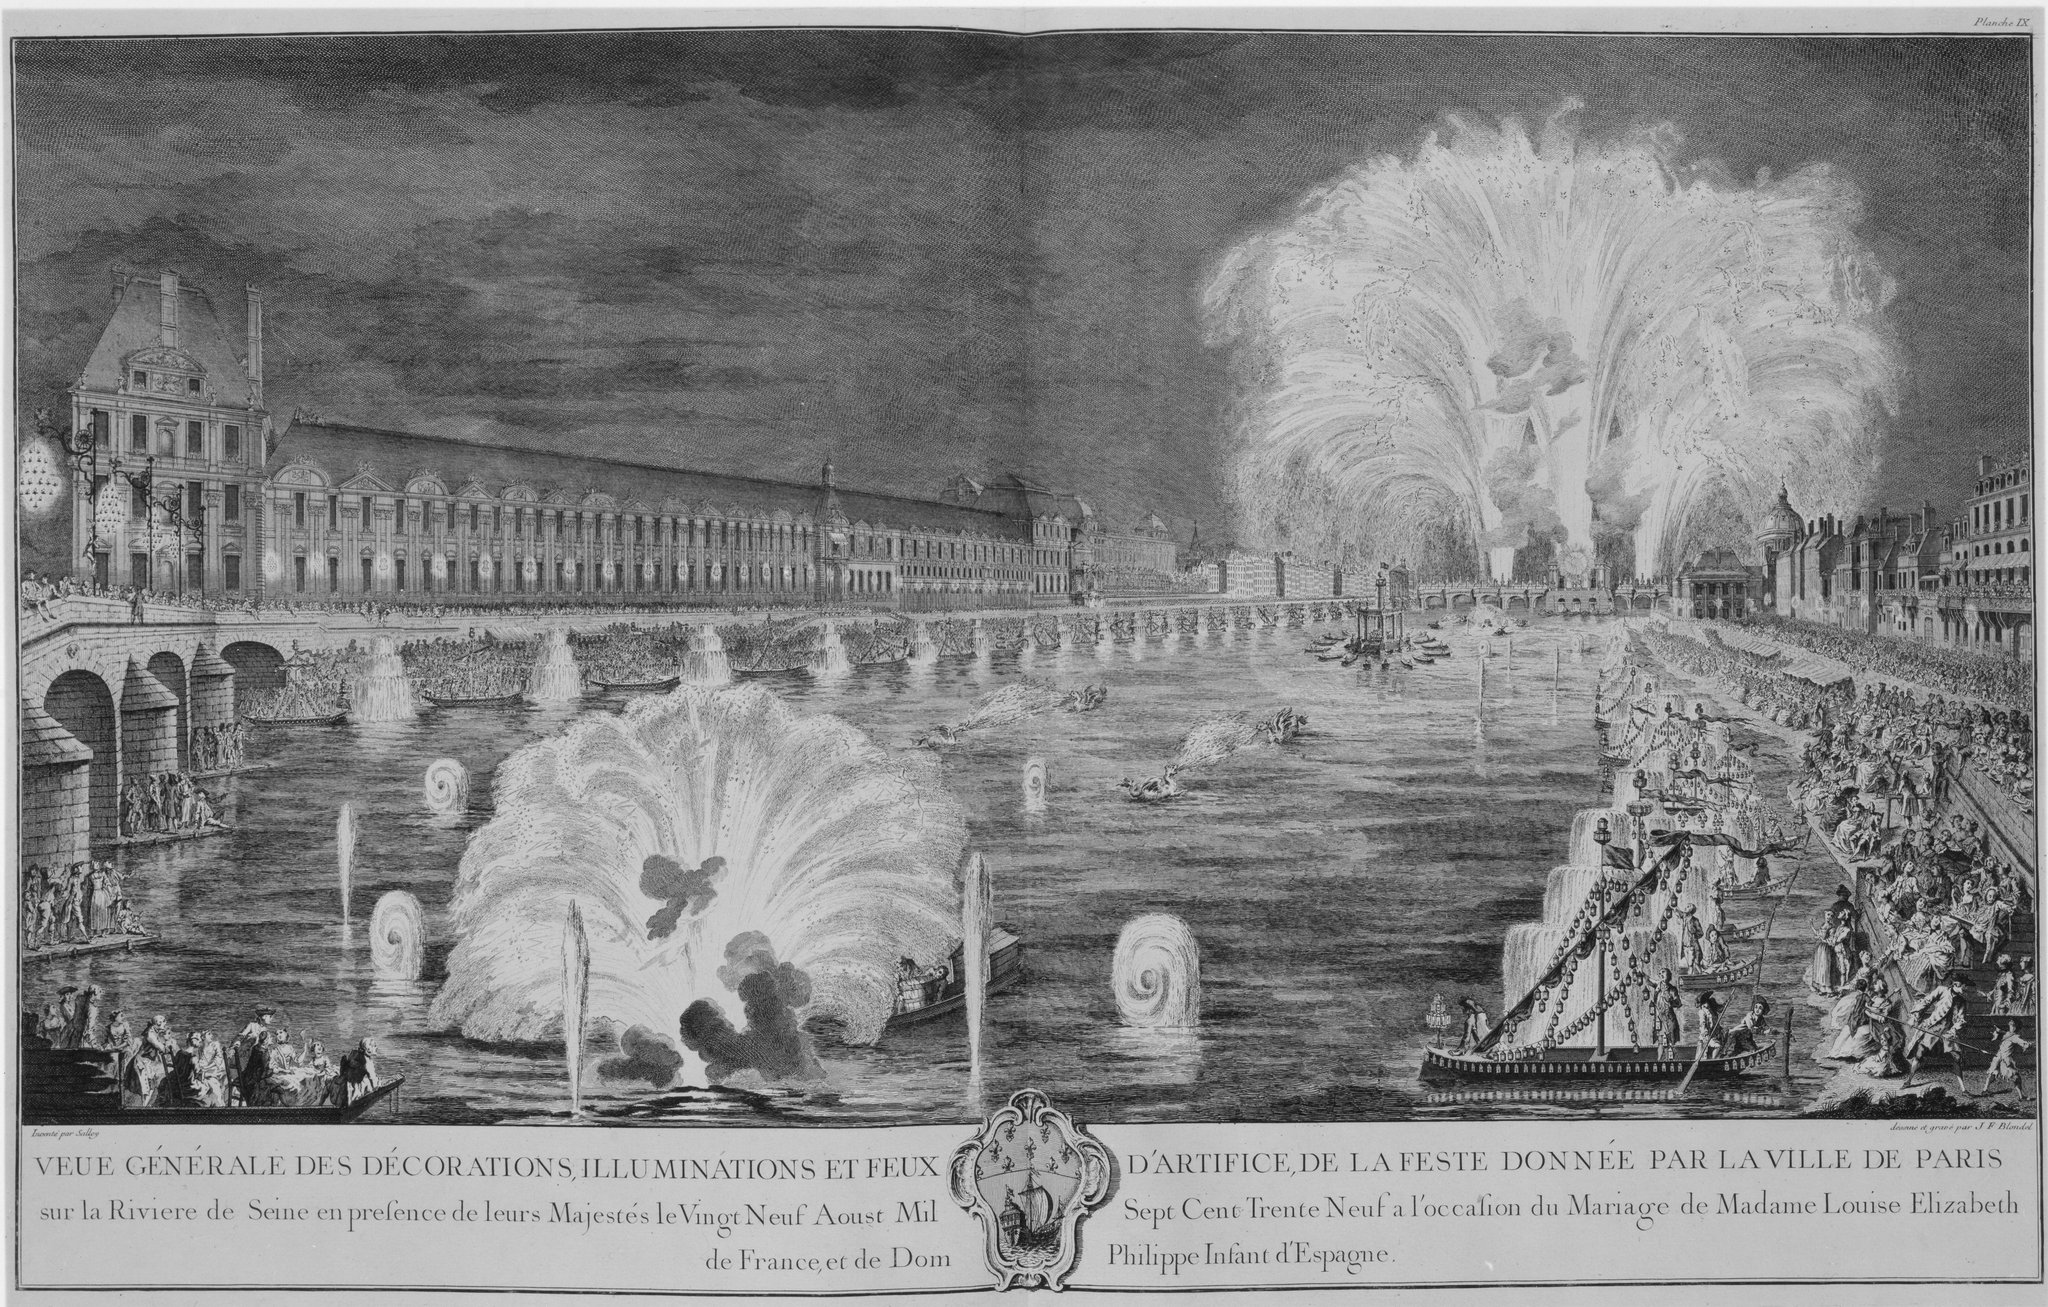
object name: print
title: Marriage of Louise-Élisabeth of France and Don Philip of Spain, Paris, August 29, 1739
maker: jacques françois blondel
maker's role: artist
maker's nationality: french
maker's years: 1705-1774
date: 1740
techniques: engraving, etching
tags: buildings,boats,paris